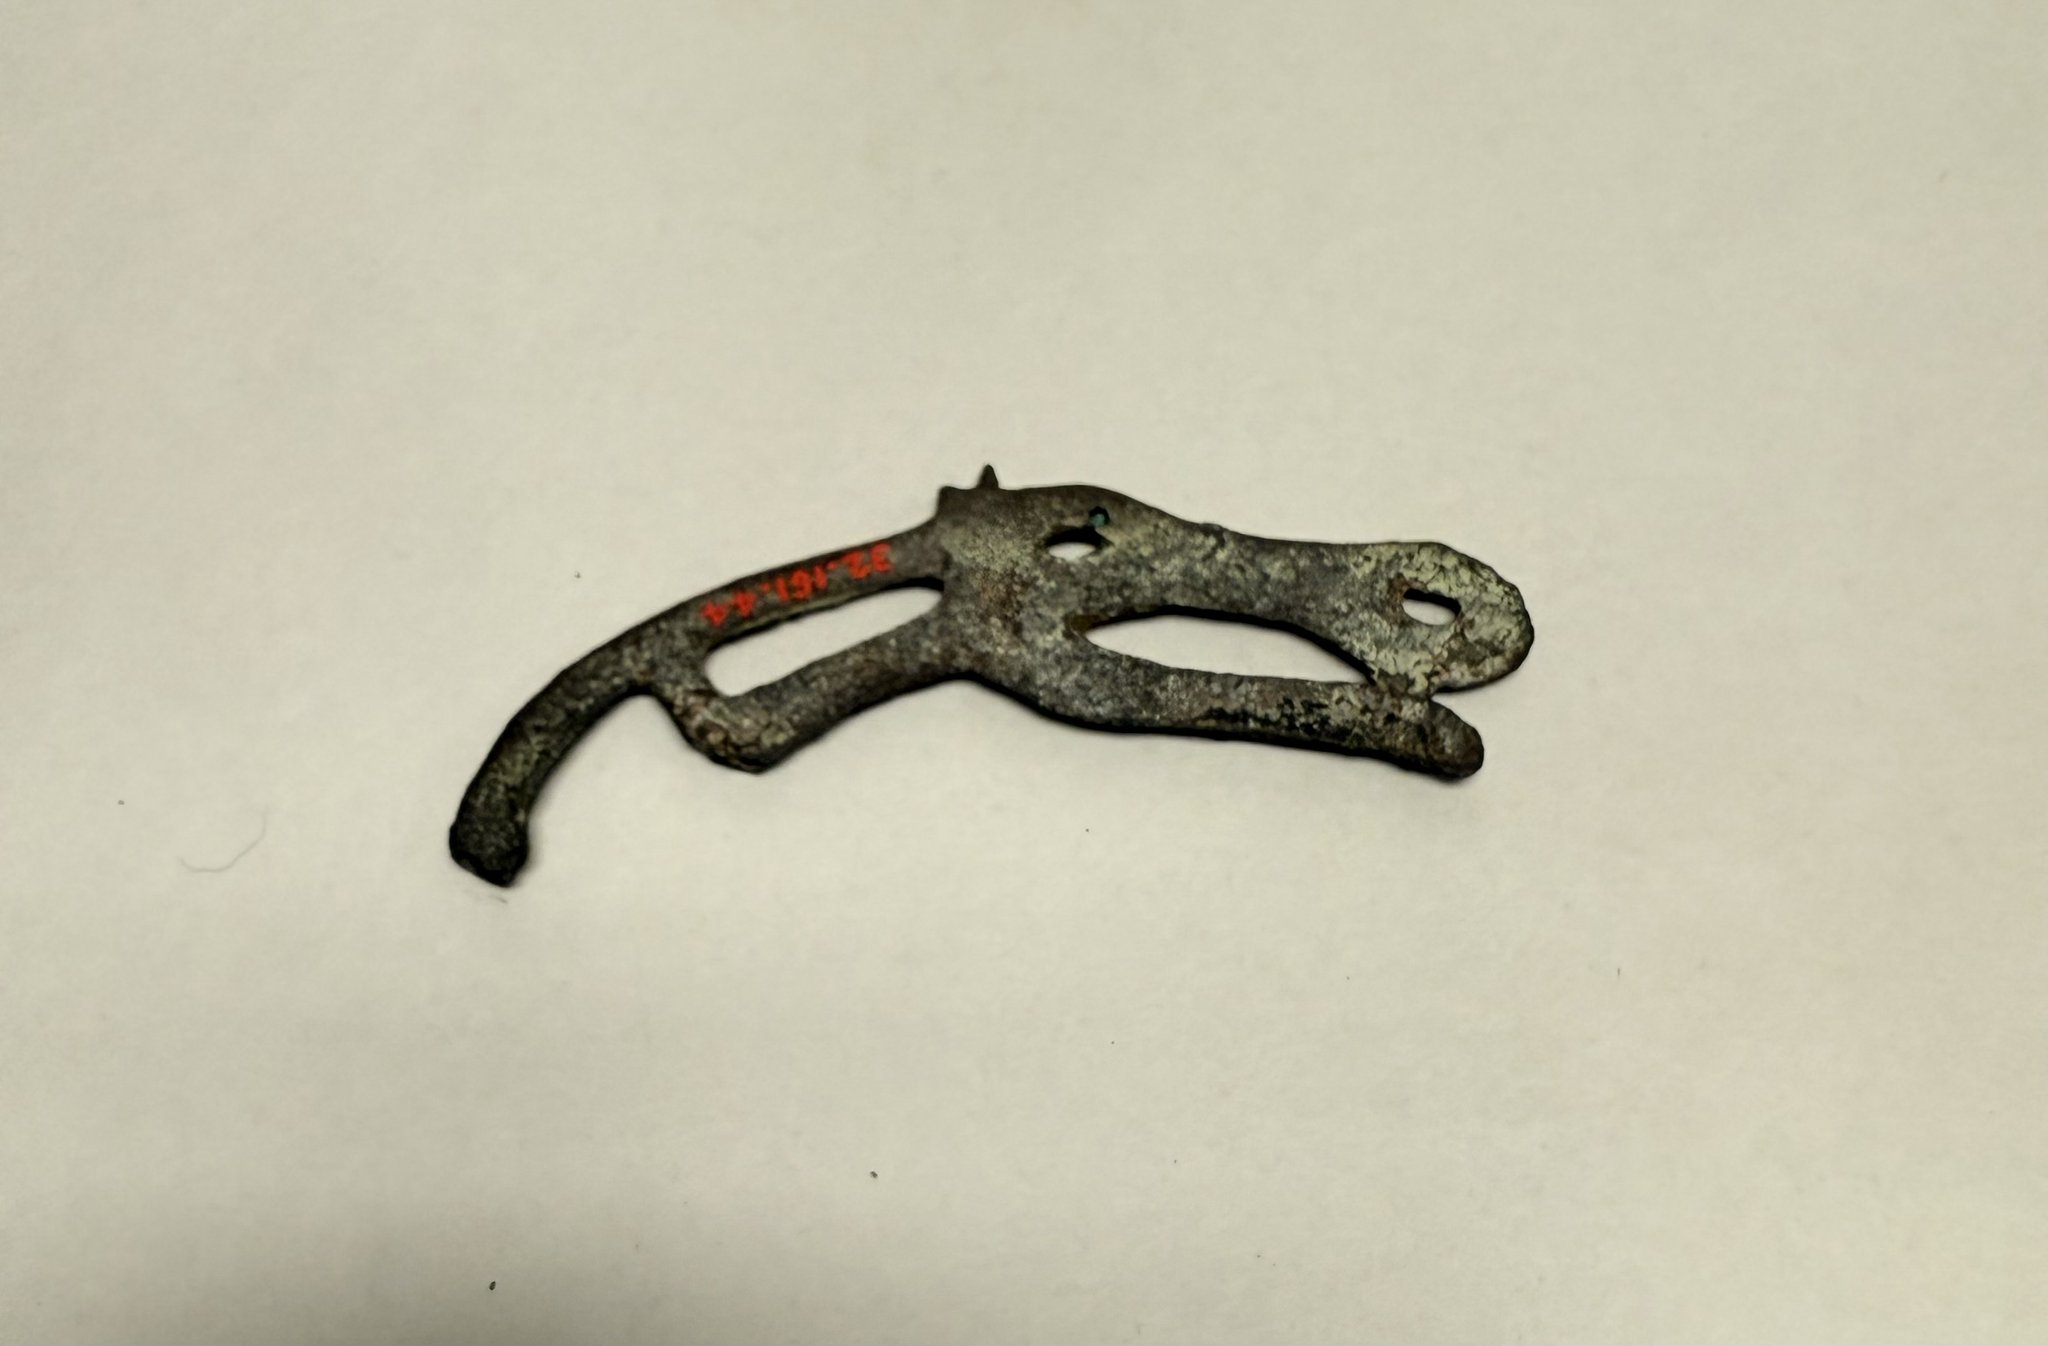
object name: plaque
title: Horse's Head Plaque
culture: western siberian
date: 1-100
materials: bronze